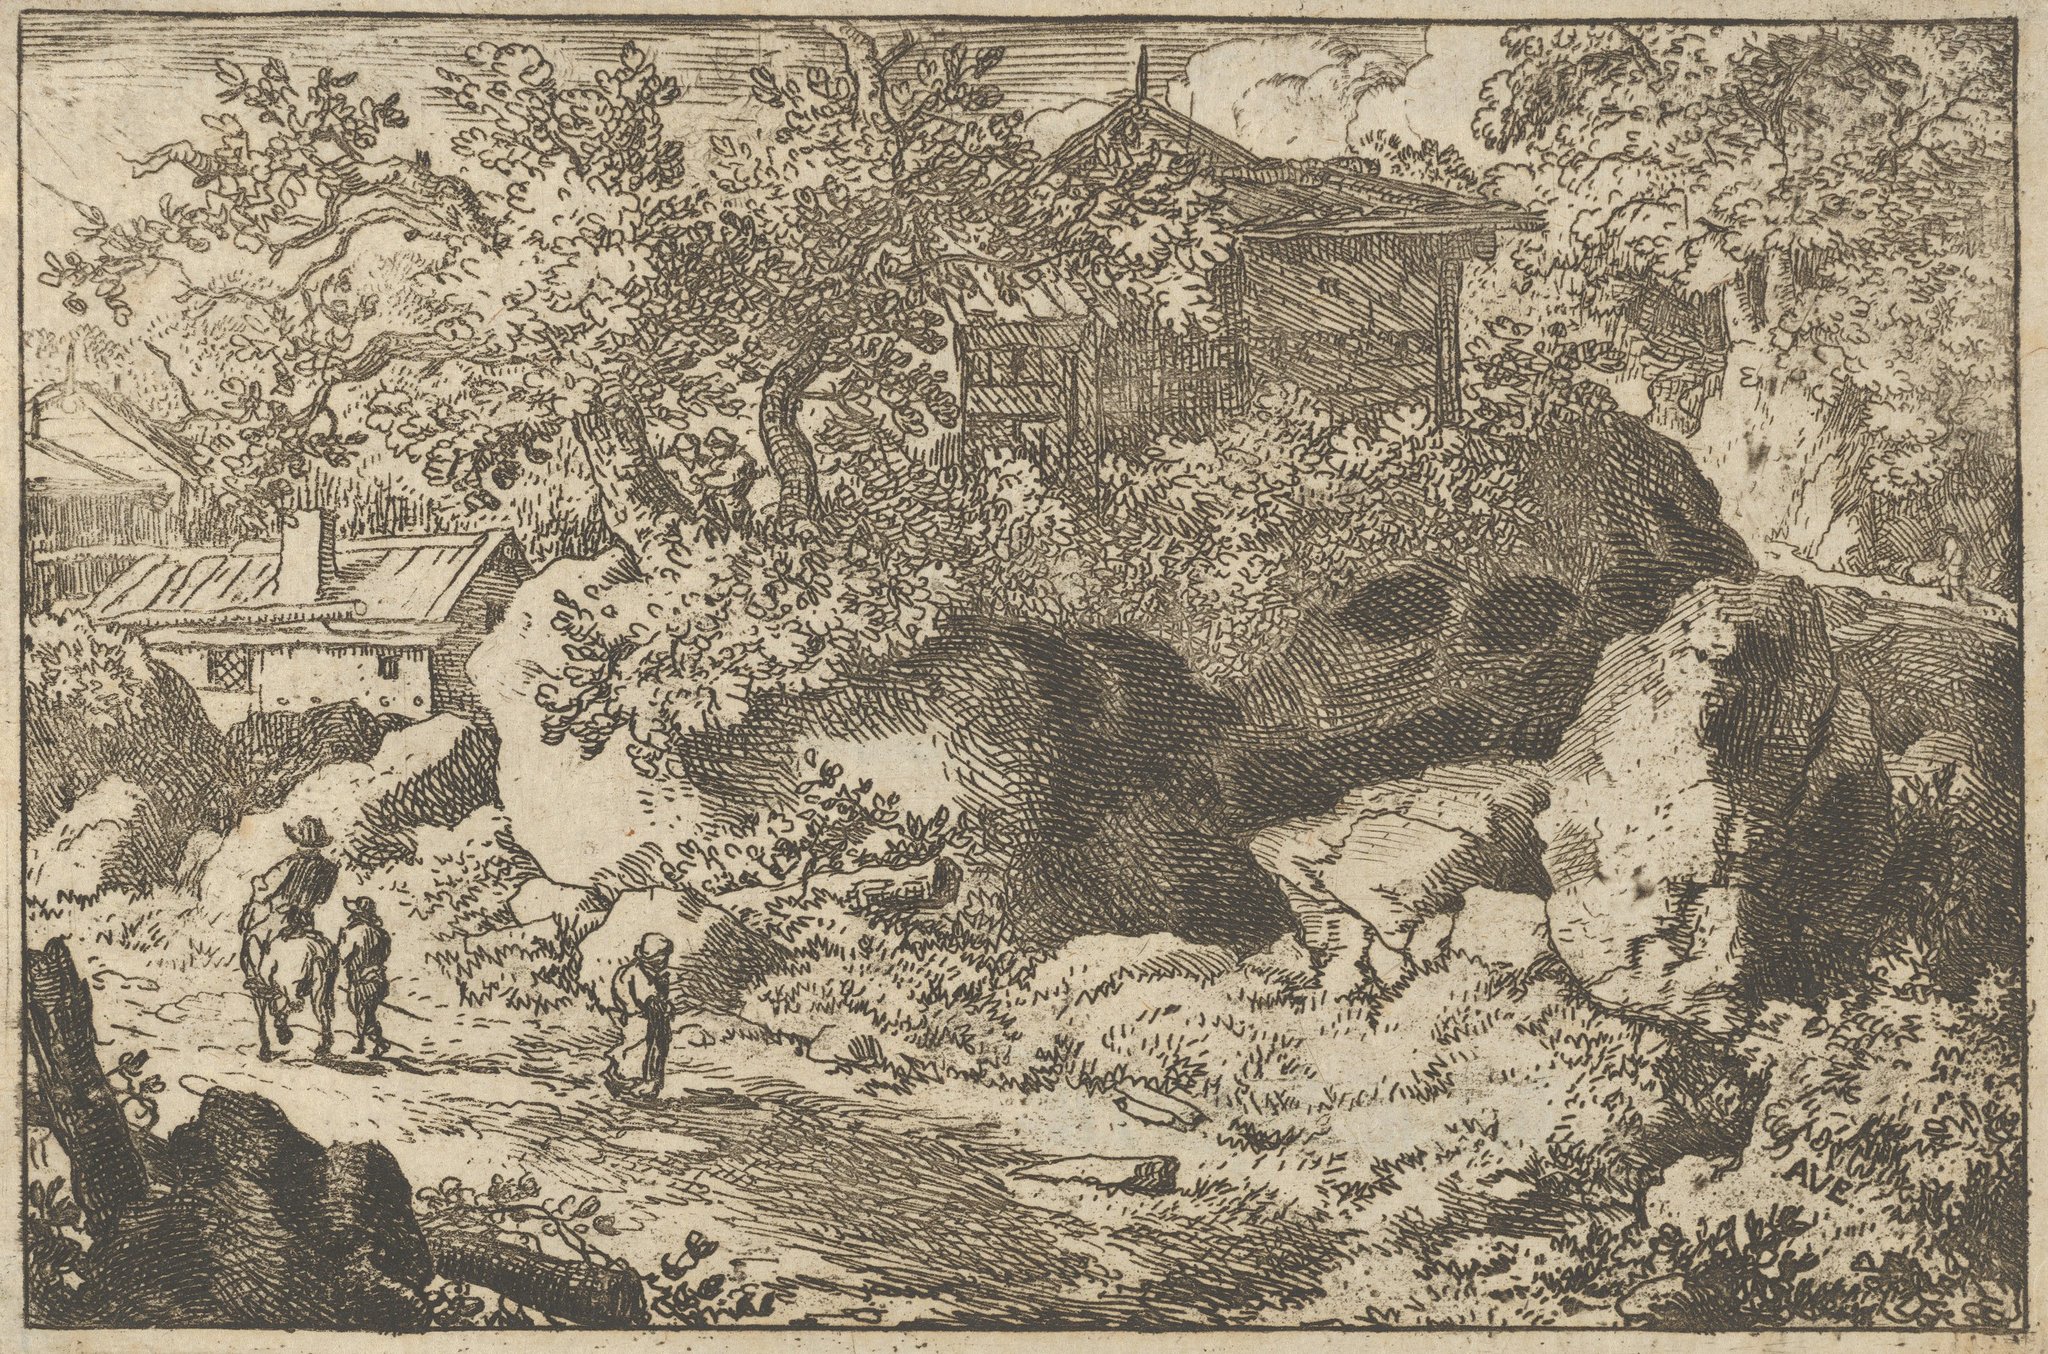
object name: print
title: The Peasant on Horseback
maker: allart van everdingen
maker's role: artist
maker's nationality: dutch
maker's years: 1621-1675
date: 1621-1675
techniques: engraving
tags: buildings,men,horses,trees